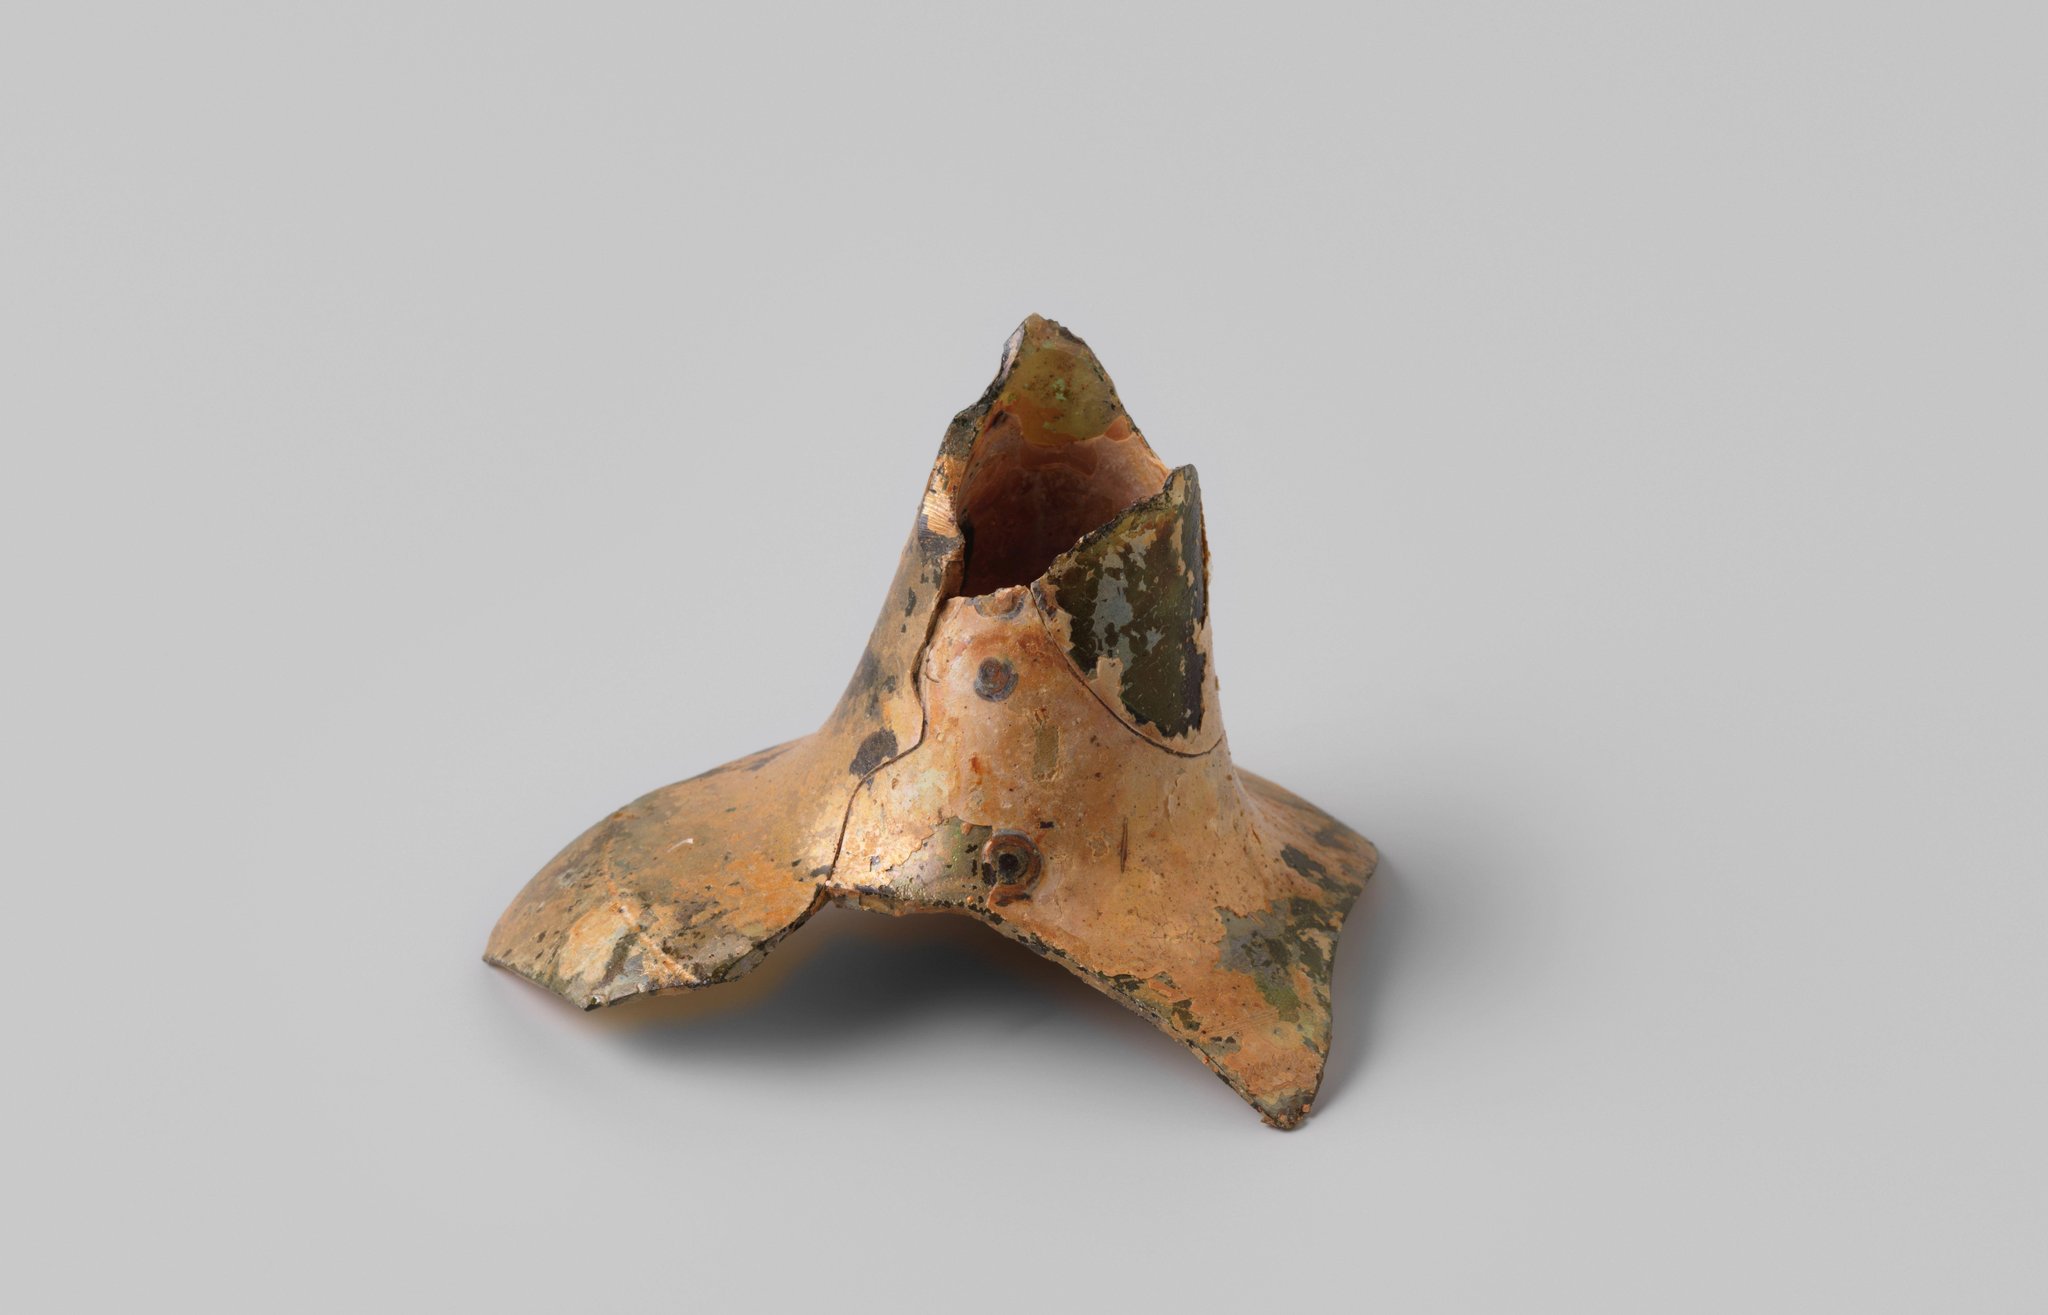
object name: neck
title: Fragment hals van een wijnfles uit het wrak van de Oost-Indiëvaarder Hollandia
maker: Anonymous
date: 1700-1743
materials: glass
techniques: green glass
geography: netherlands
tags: verenigde oostindische compagnie, hollandia (schip), annet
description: Wine bottle, continental production, neck, onion-shaped bottle or bottle with vertical side; fragm, mouth missing.